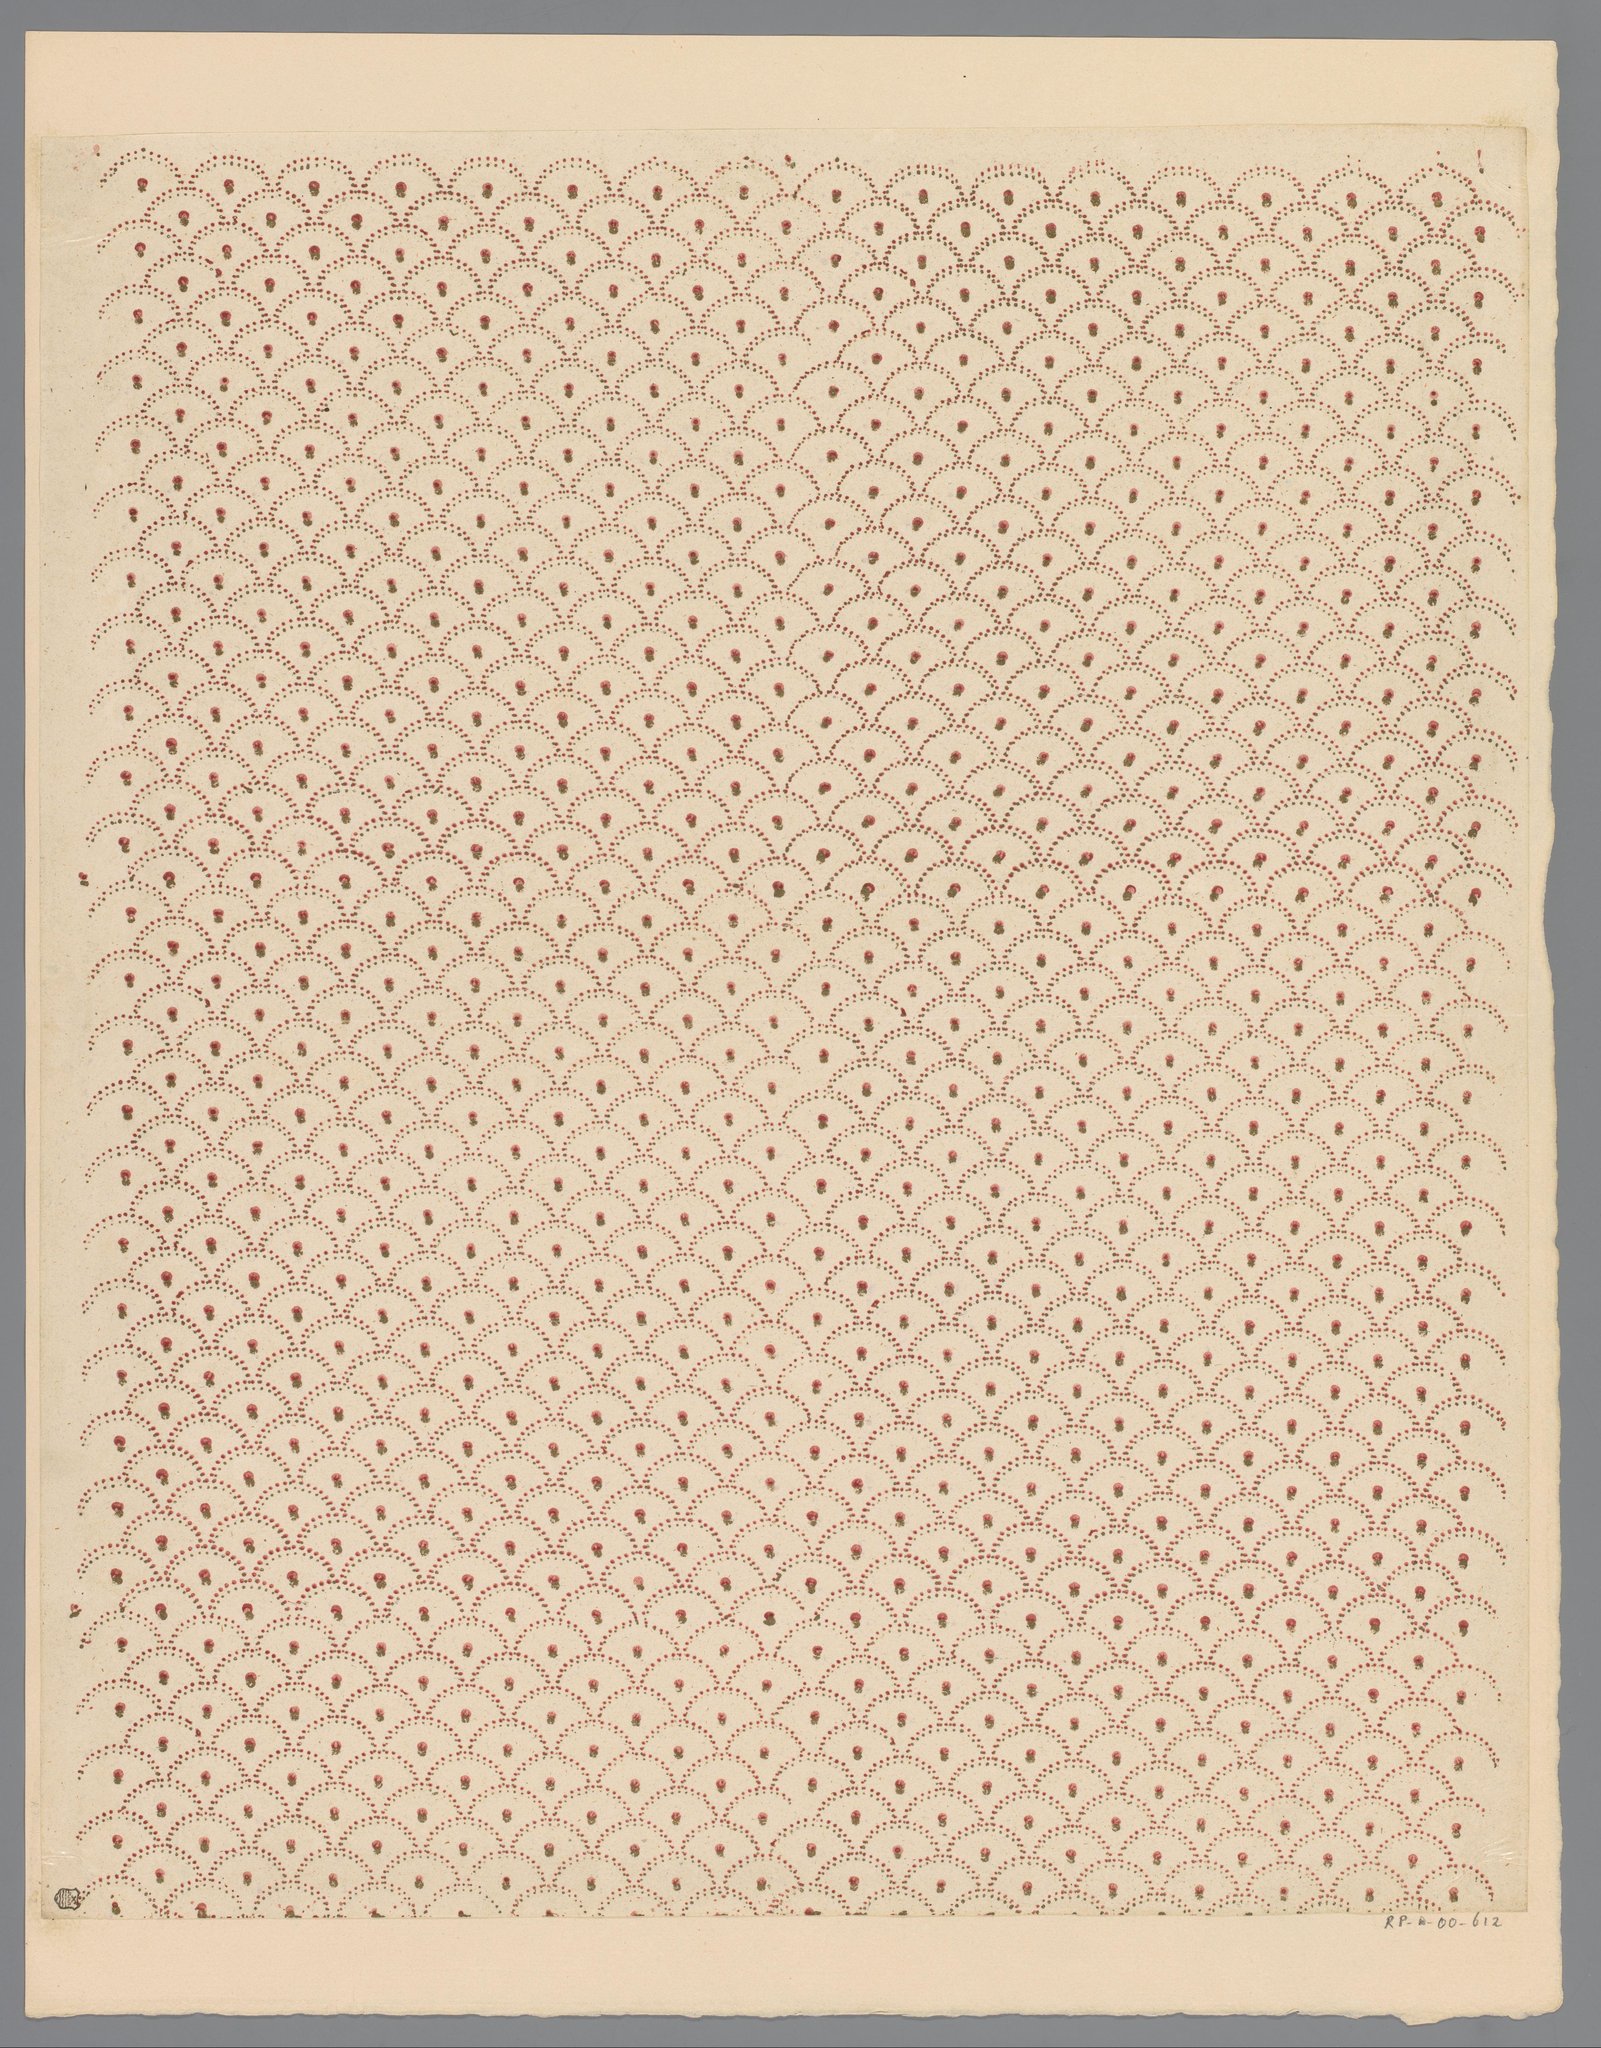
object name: printed paper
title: Blad met schubbenpatroon met stippen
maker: Anonymous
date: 1800-1900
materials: paint, paper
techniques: printing block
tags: ornament derived from animal forms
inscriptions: collector's mark: Lugt 2760